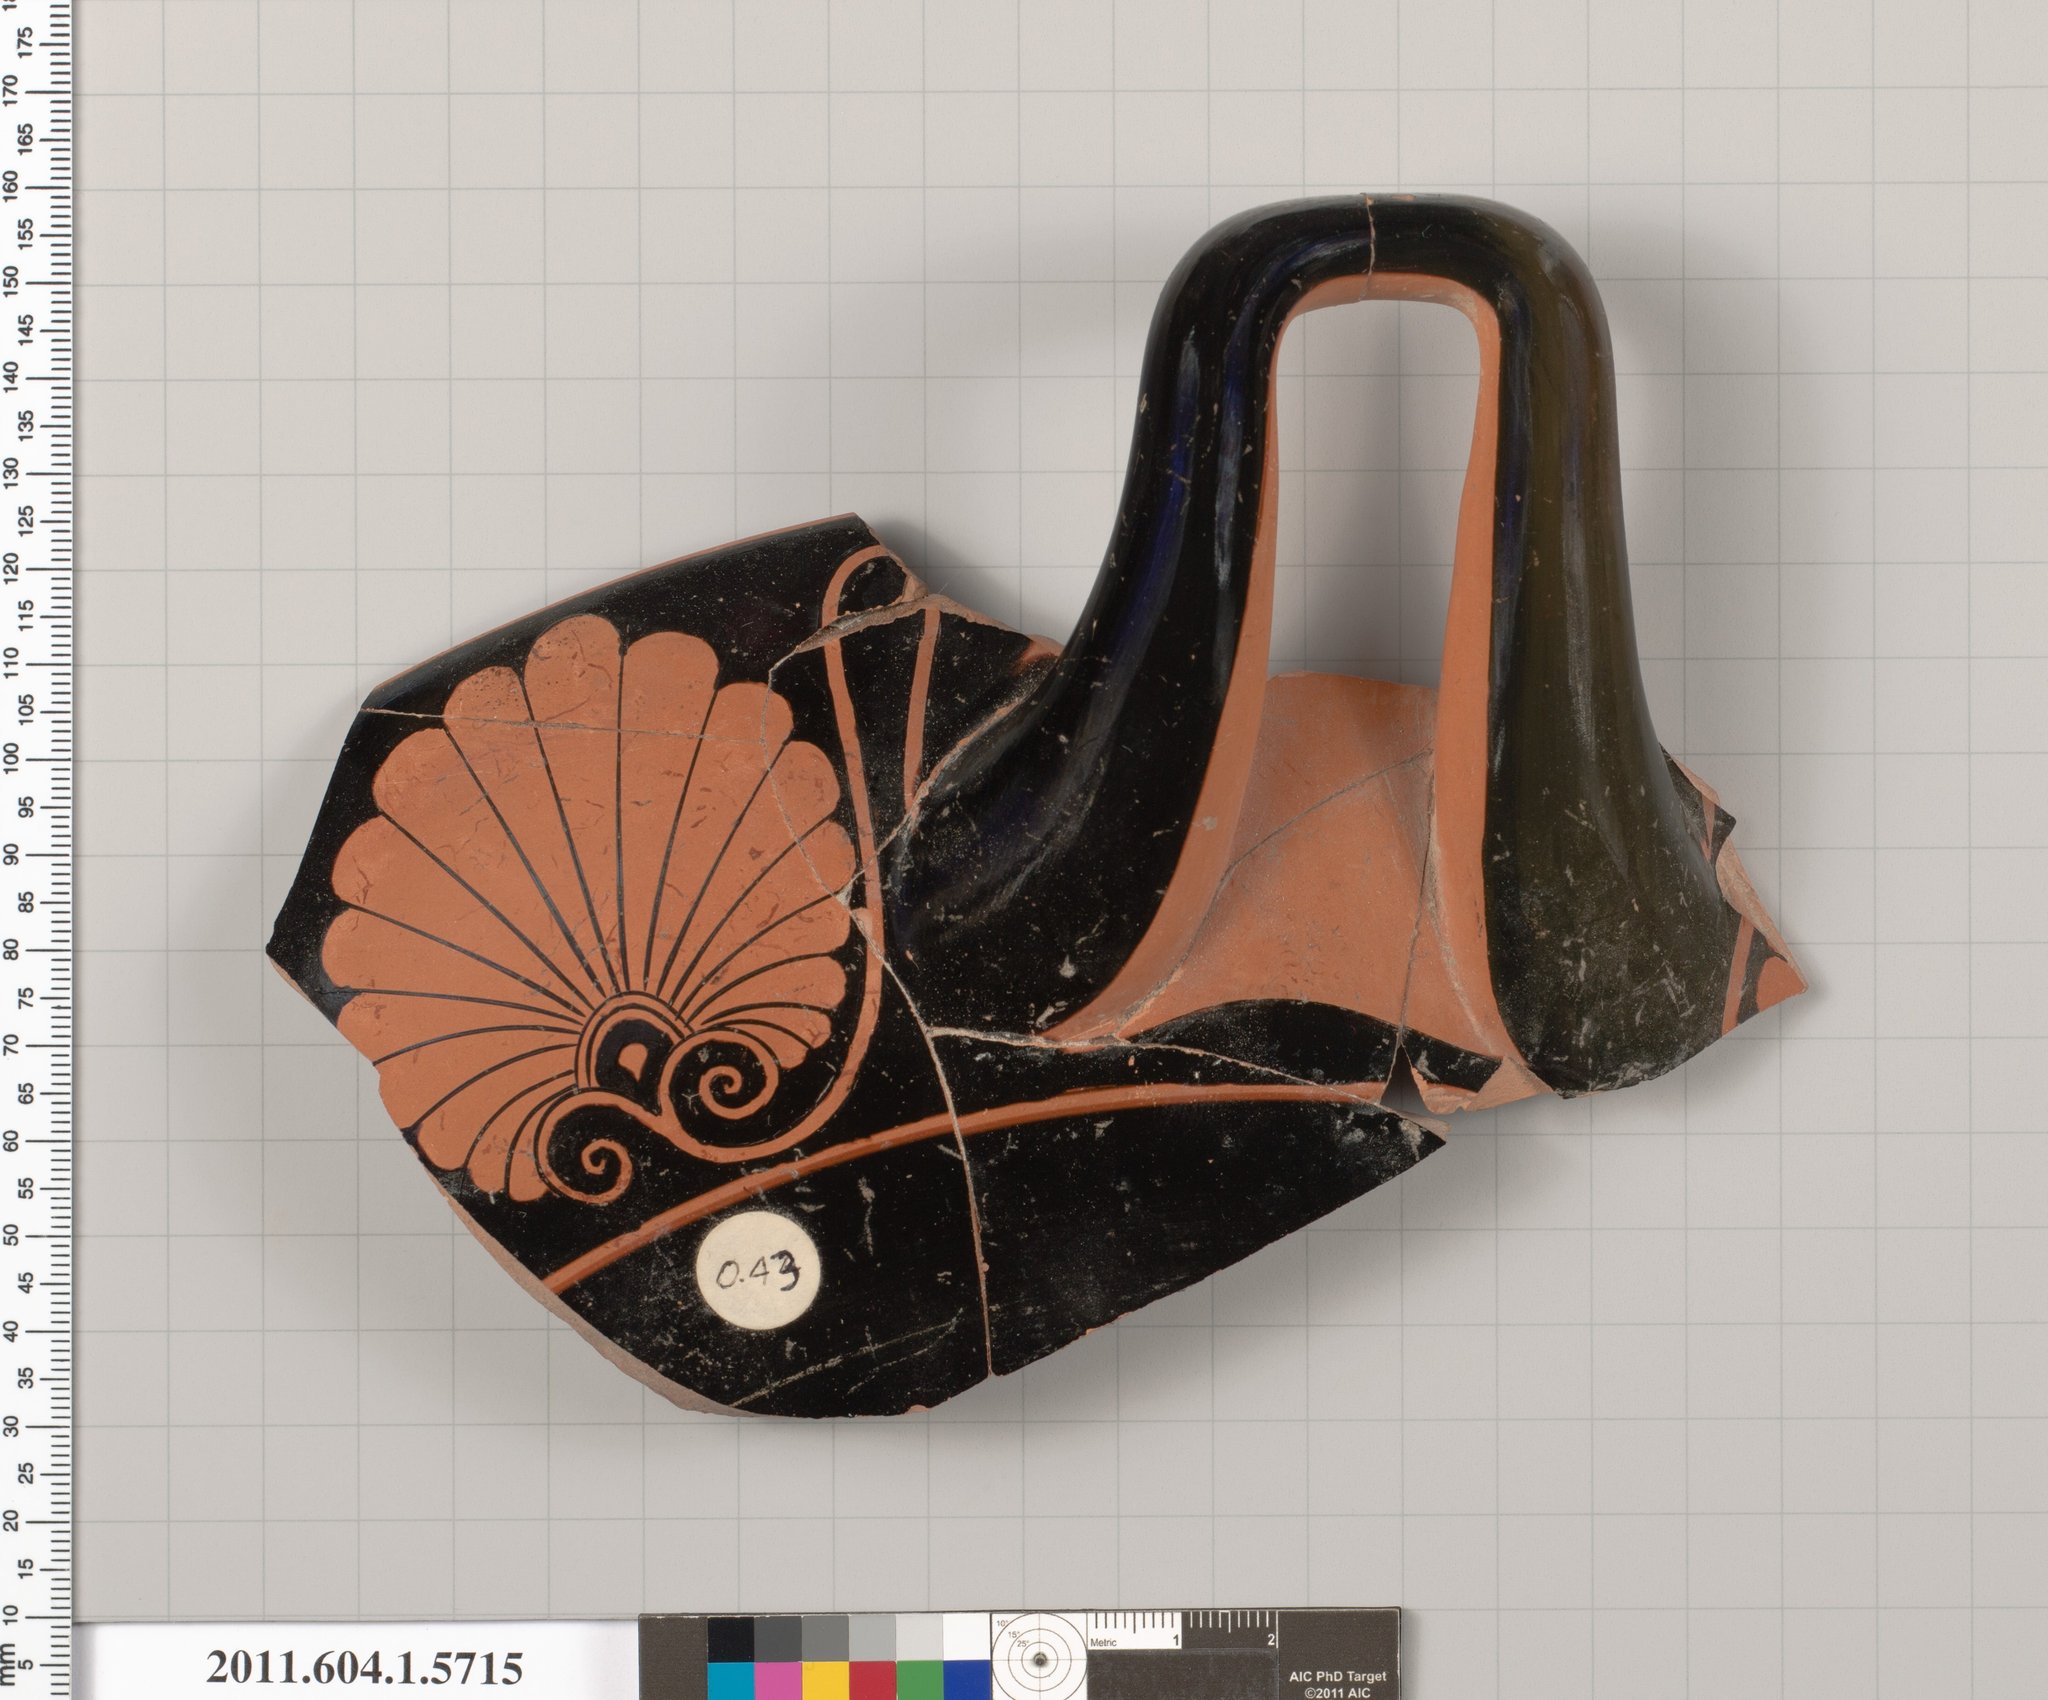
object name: kylix fragment, eye cup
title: Terracotta fragment of a kylix: eye-cup (drinking cup)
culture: greek, attic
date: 520-510 BCE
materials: terracotta